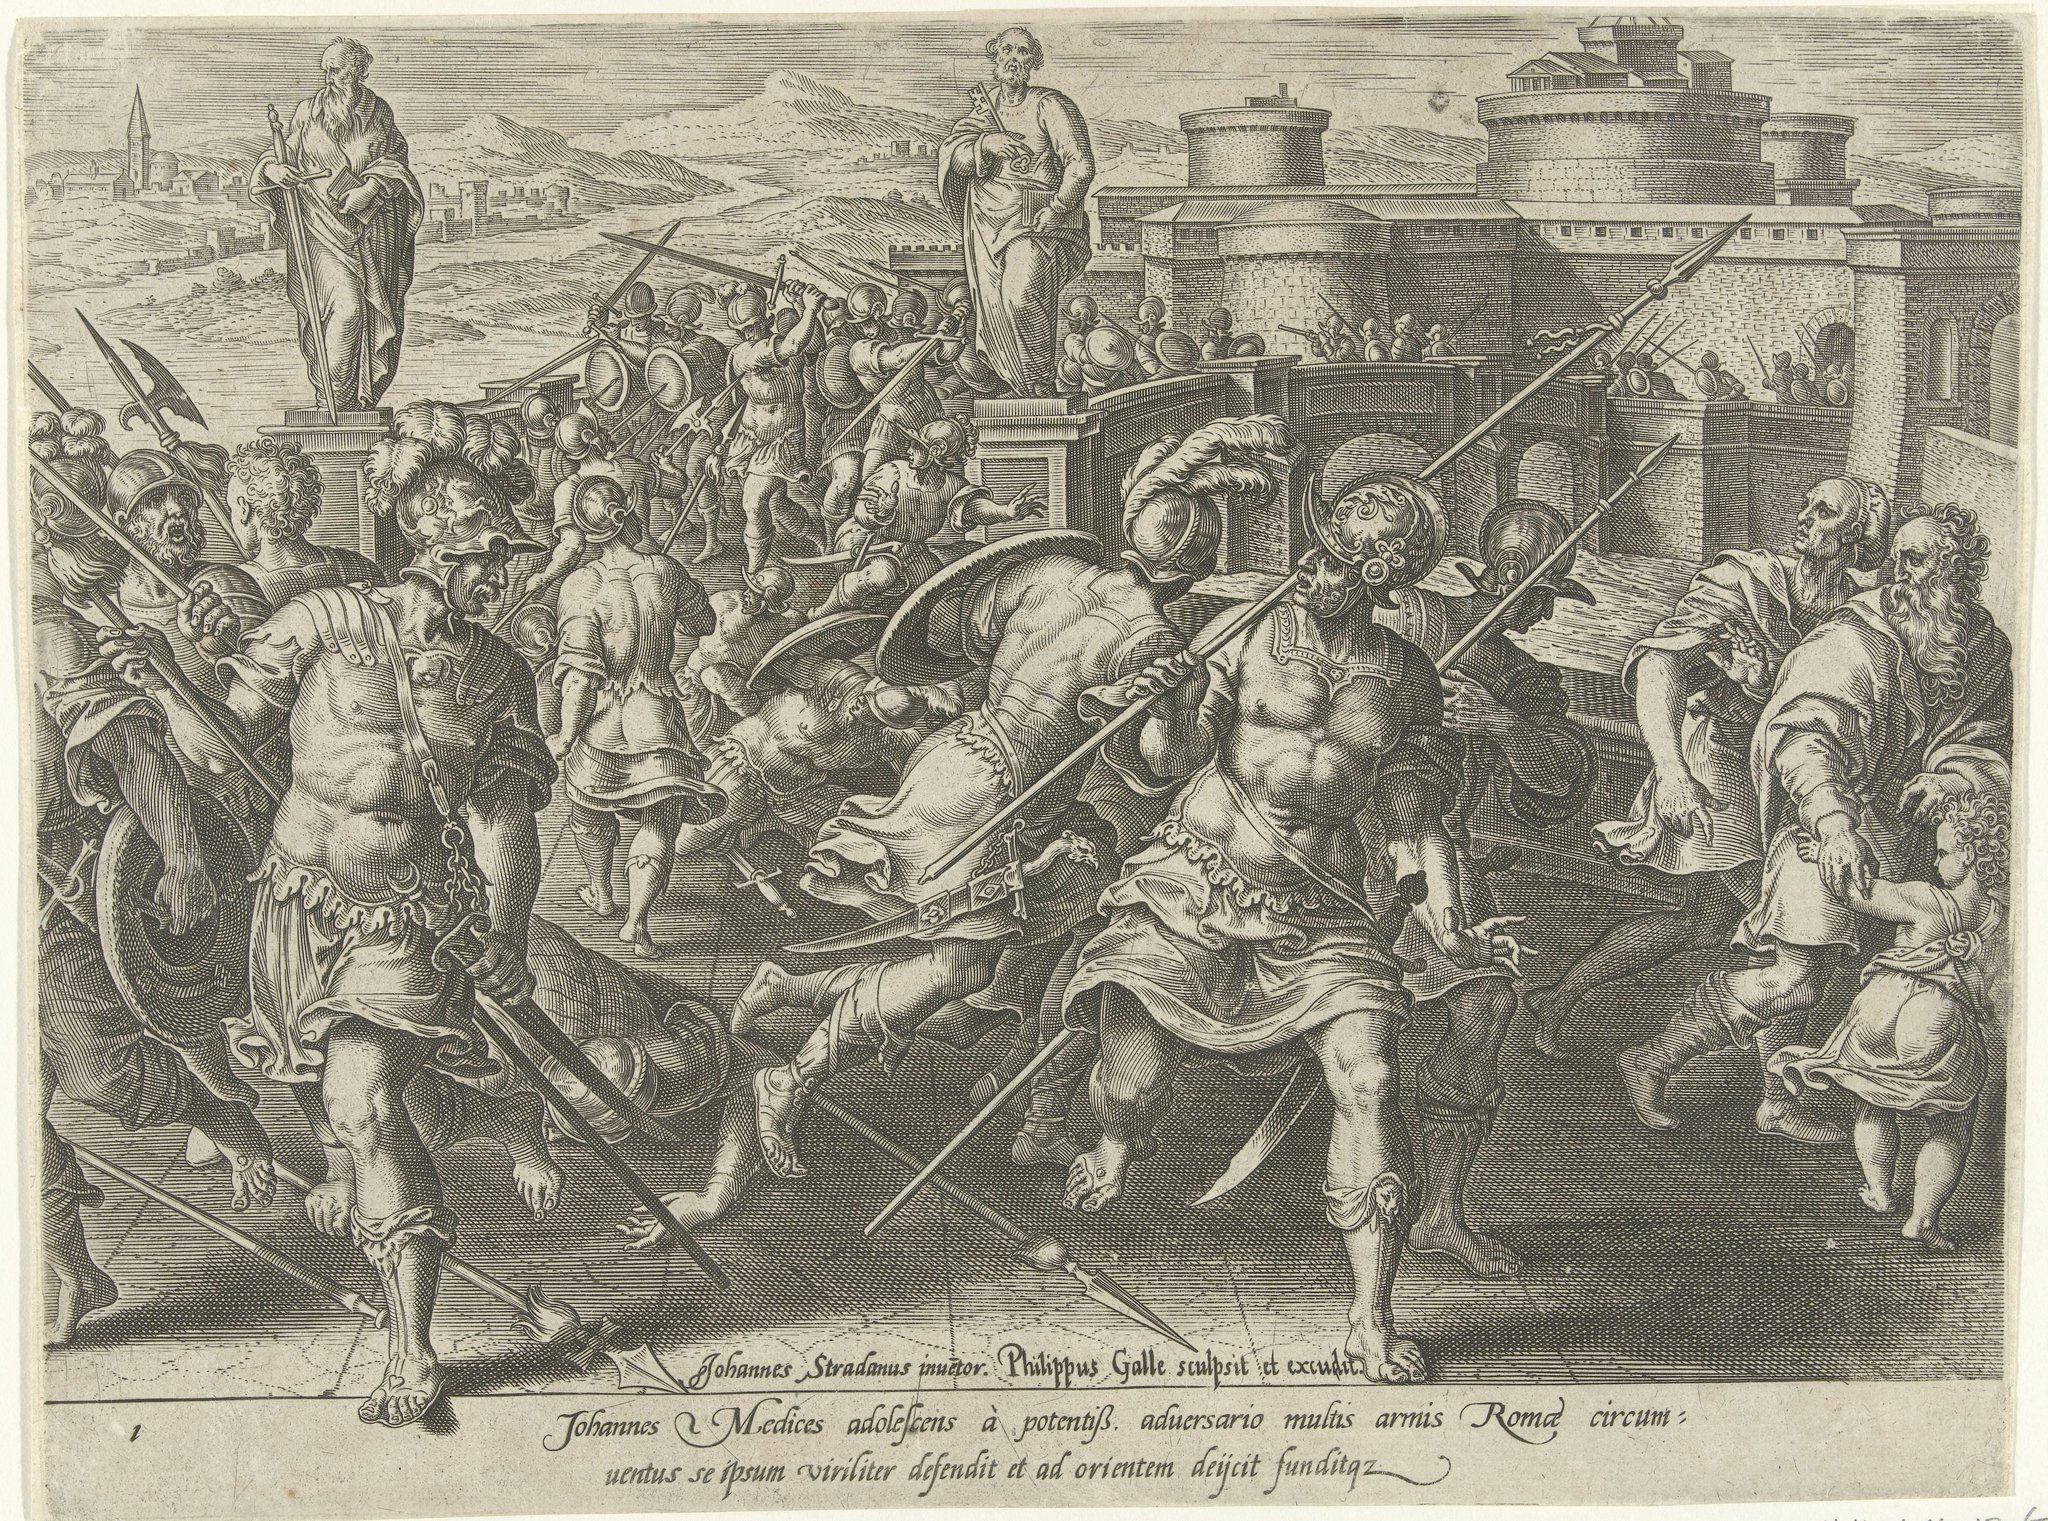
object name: print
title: Mediceae Familiae rerum feliciter gestarum victoriae et triumphi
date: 1583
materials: paper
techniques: engraving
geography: florence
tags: rome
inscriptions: collector's mark: Lugt 2228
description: De jonge Giovanni de Medici, genoemd 'dalle Bande Nere', wordt tijdens een straatgevecht op de Engelenbrug omsingeld door leden van de Orsini-familie. Hij slaat wild om zich heen met zijn zwaard en jaagt de belegeraars op de vlucht. De prent heeft een Latijns onderschrift en maakt deel uit van een serie over de familiegeschiedenis van het geslacht De' Medici.